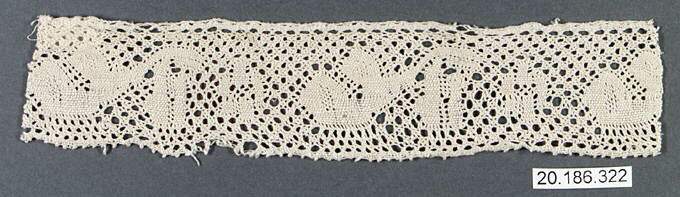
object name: edging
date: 1701-1800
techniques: lace